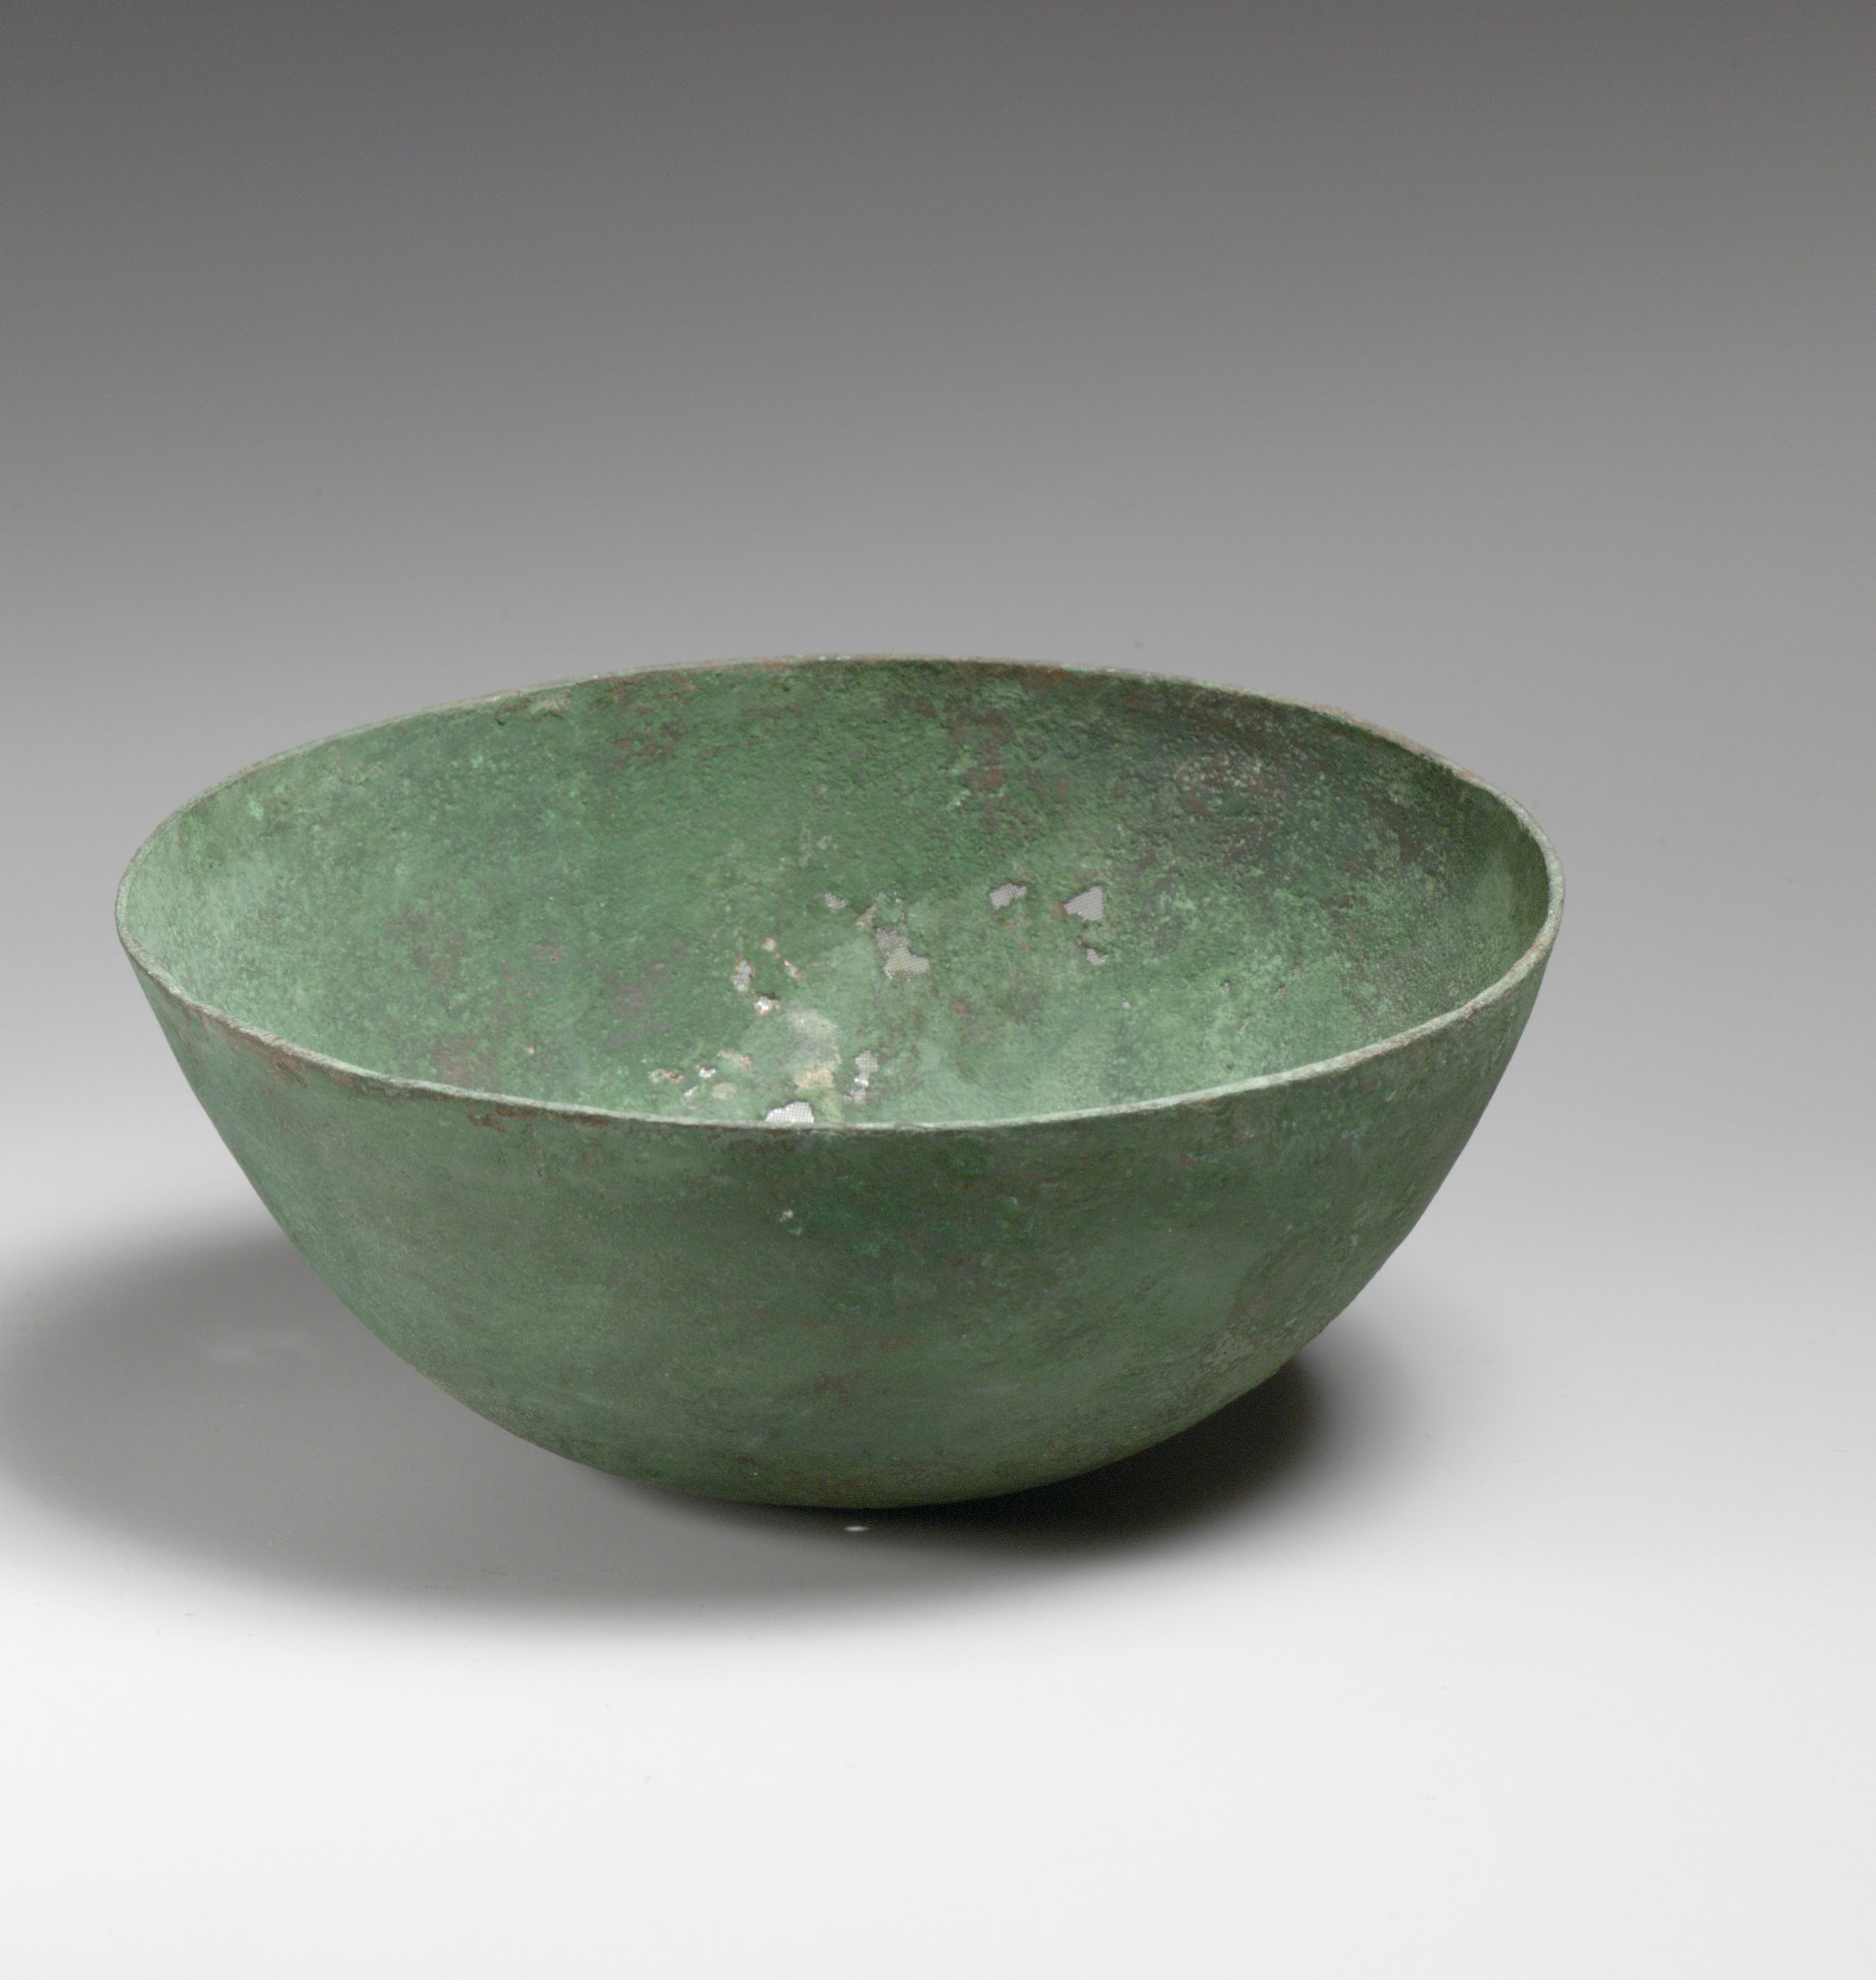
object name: bowl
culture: cypriot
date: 3900 BCE-100 CE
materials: bronze